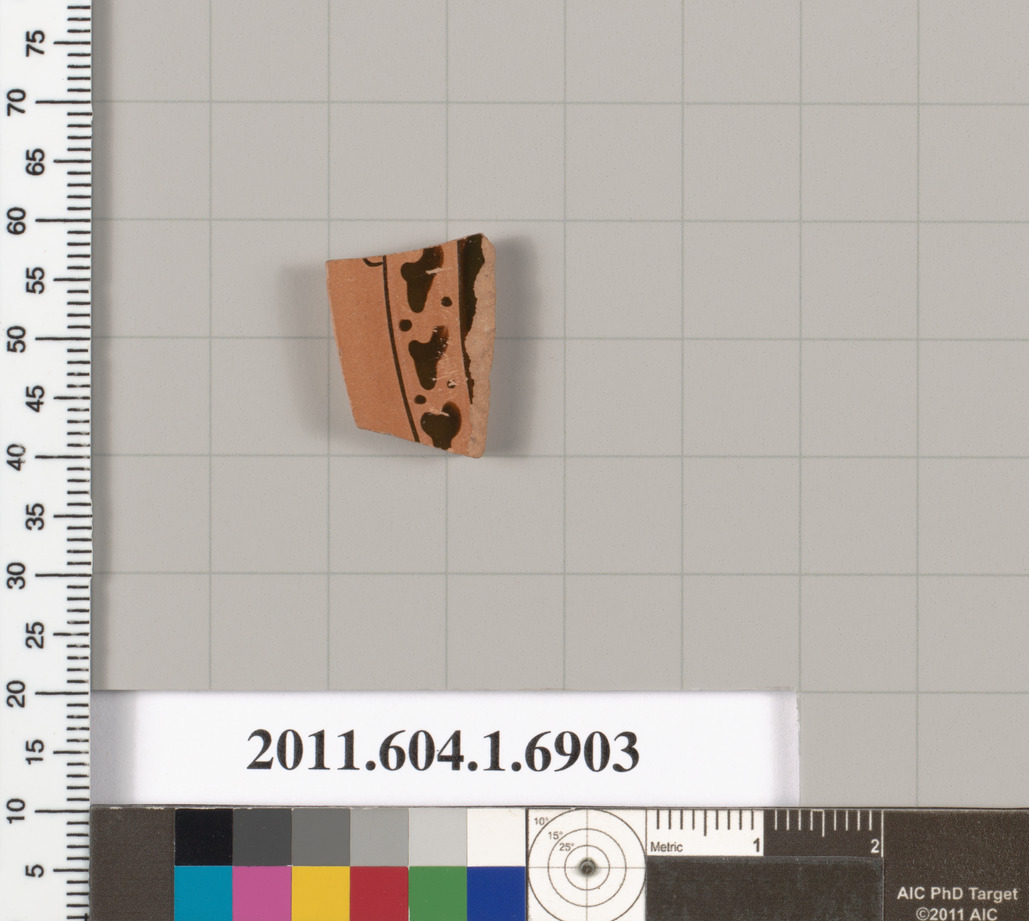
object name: kylix fragment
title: Terracotta fragment of a kylix (drinking cup)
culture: greek, attic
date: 490-470 BCE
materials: terracotta